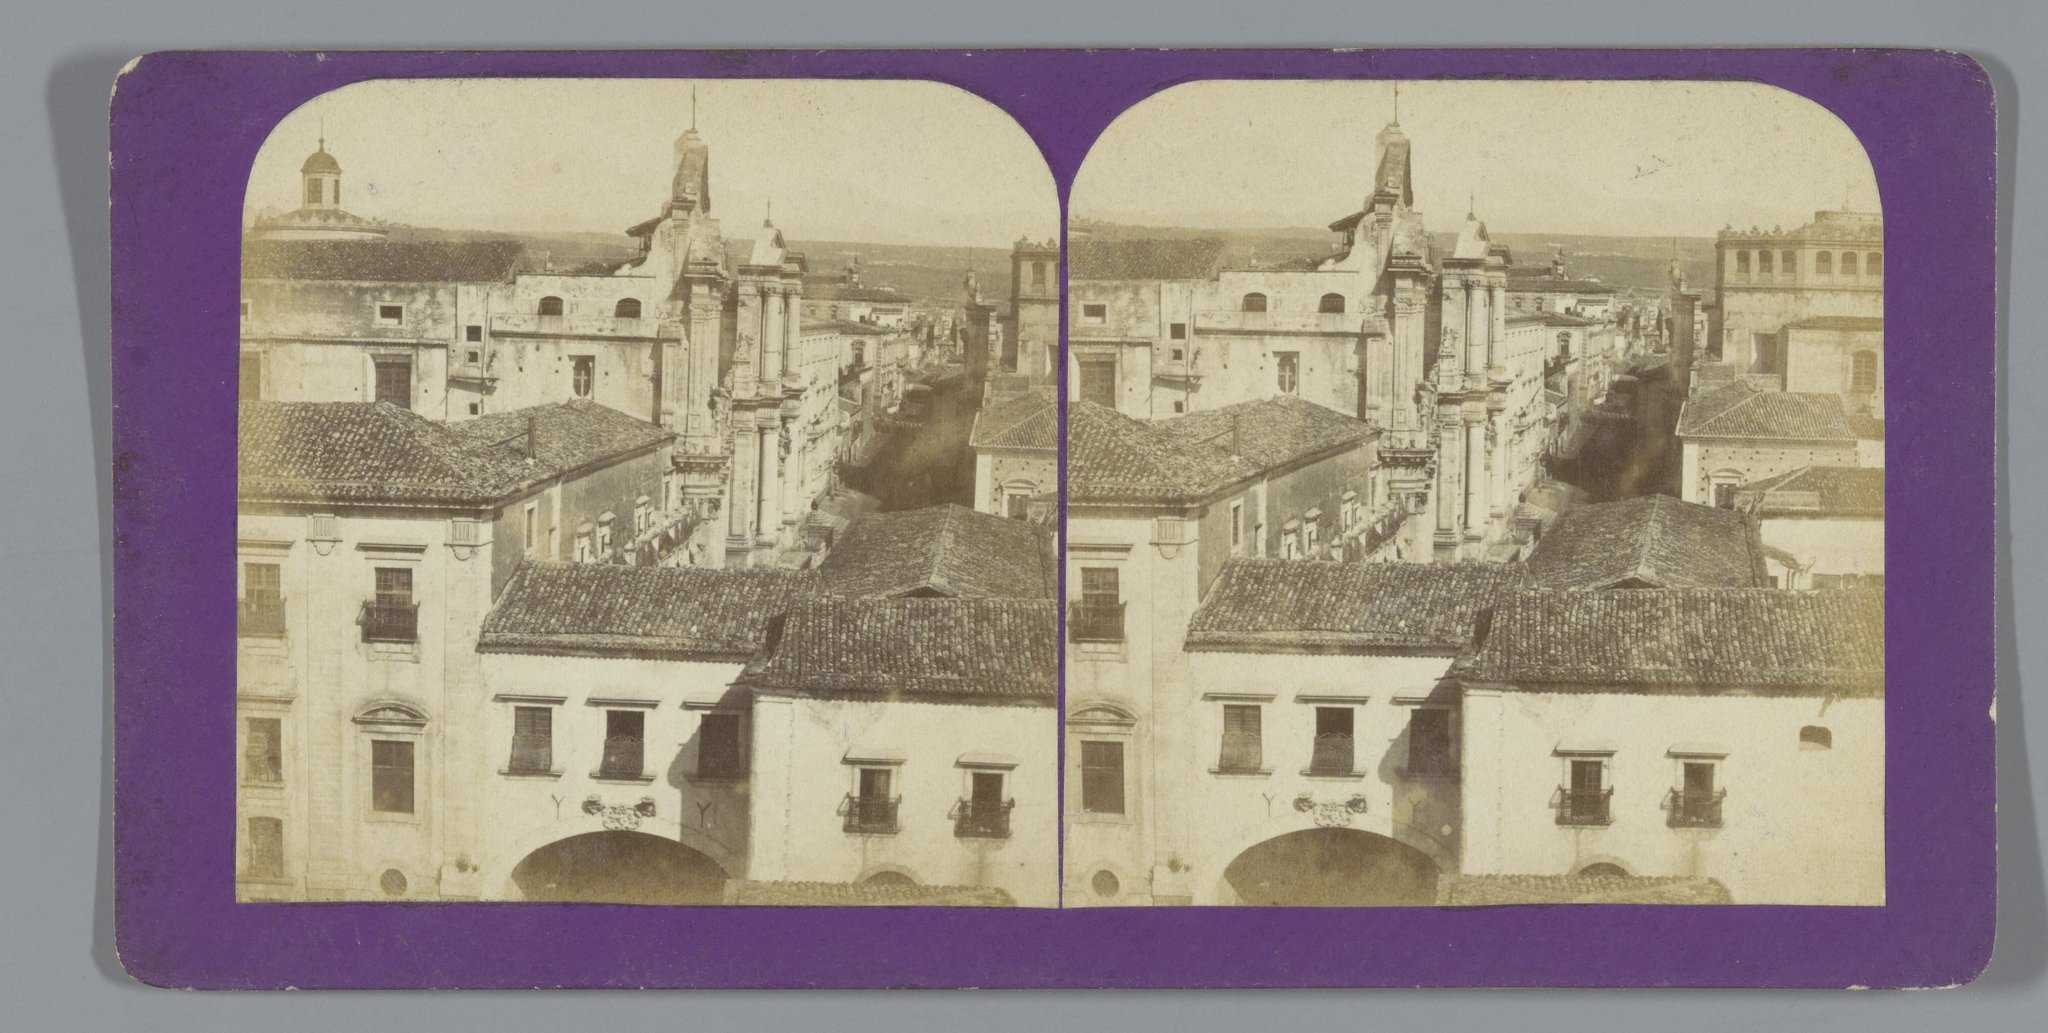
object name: stereograph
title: Gezicht op een stad aan de voet van de Etna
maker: jean andrieu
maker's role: fotograaf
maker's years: 1816-1872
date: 1862-1876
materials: cardboard, paper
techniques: albumen print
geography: catania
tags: city-view in general; 'veduta'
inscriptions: title: ‘1384 Vue générale de l'étna’